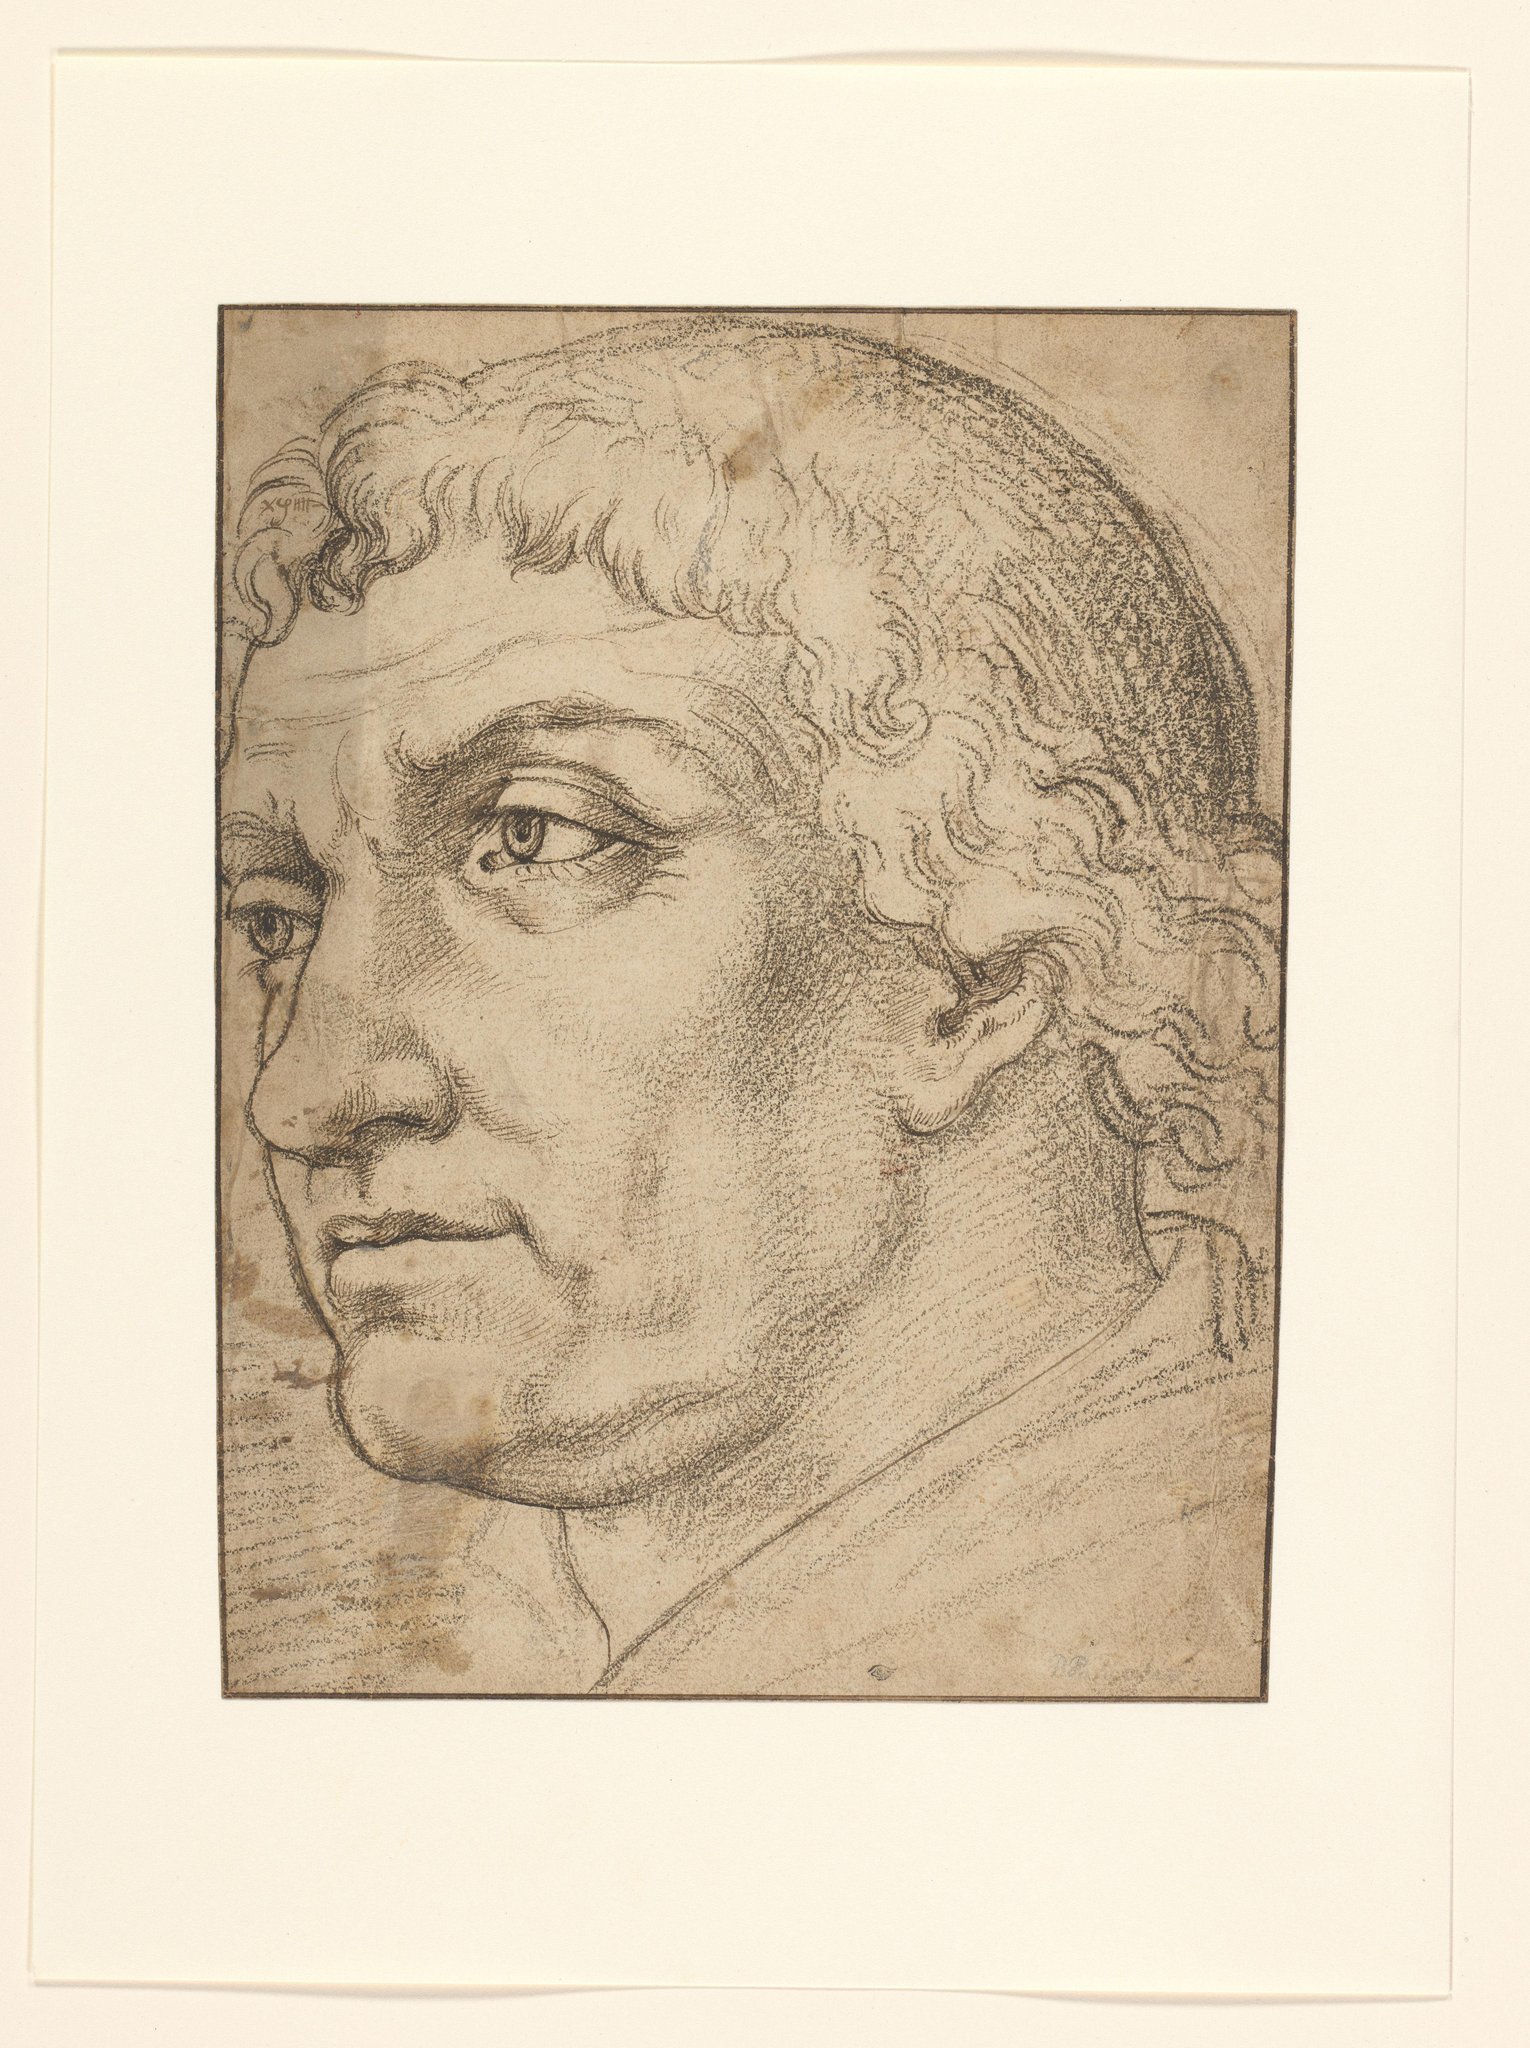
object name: drawing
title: Studie voor het hoofd van een priester (?)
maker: dirck pietersz. crabeth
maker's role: draughtsman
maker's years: 1520-1574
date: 1545-1574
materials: chalk, ink, paper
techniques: pen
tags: head (human)